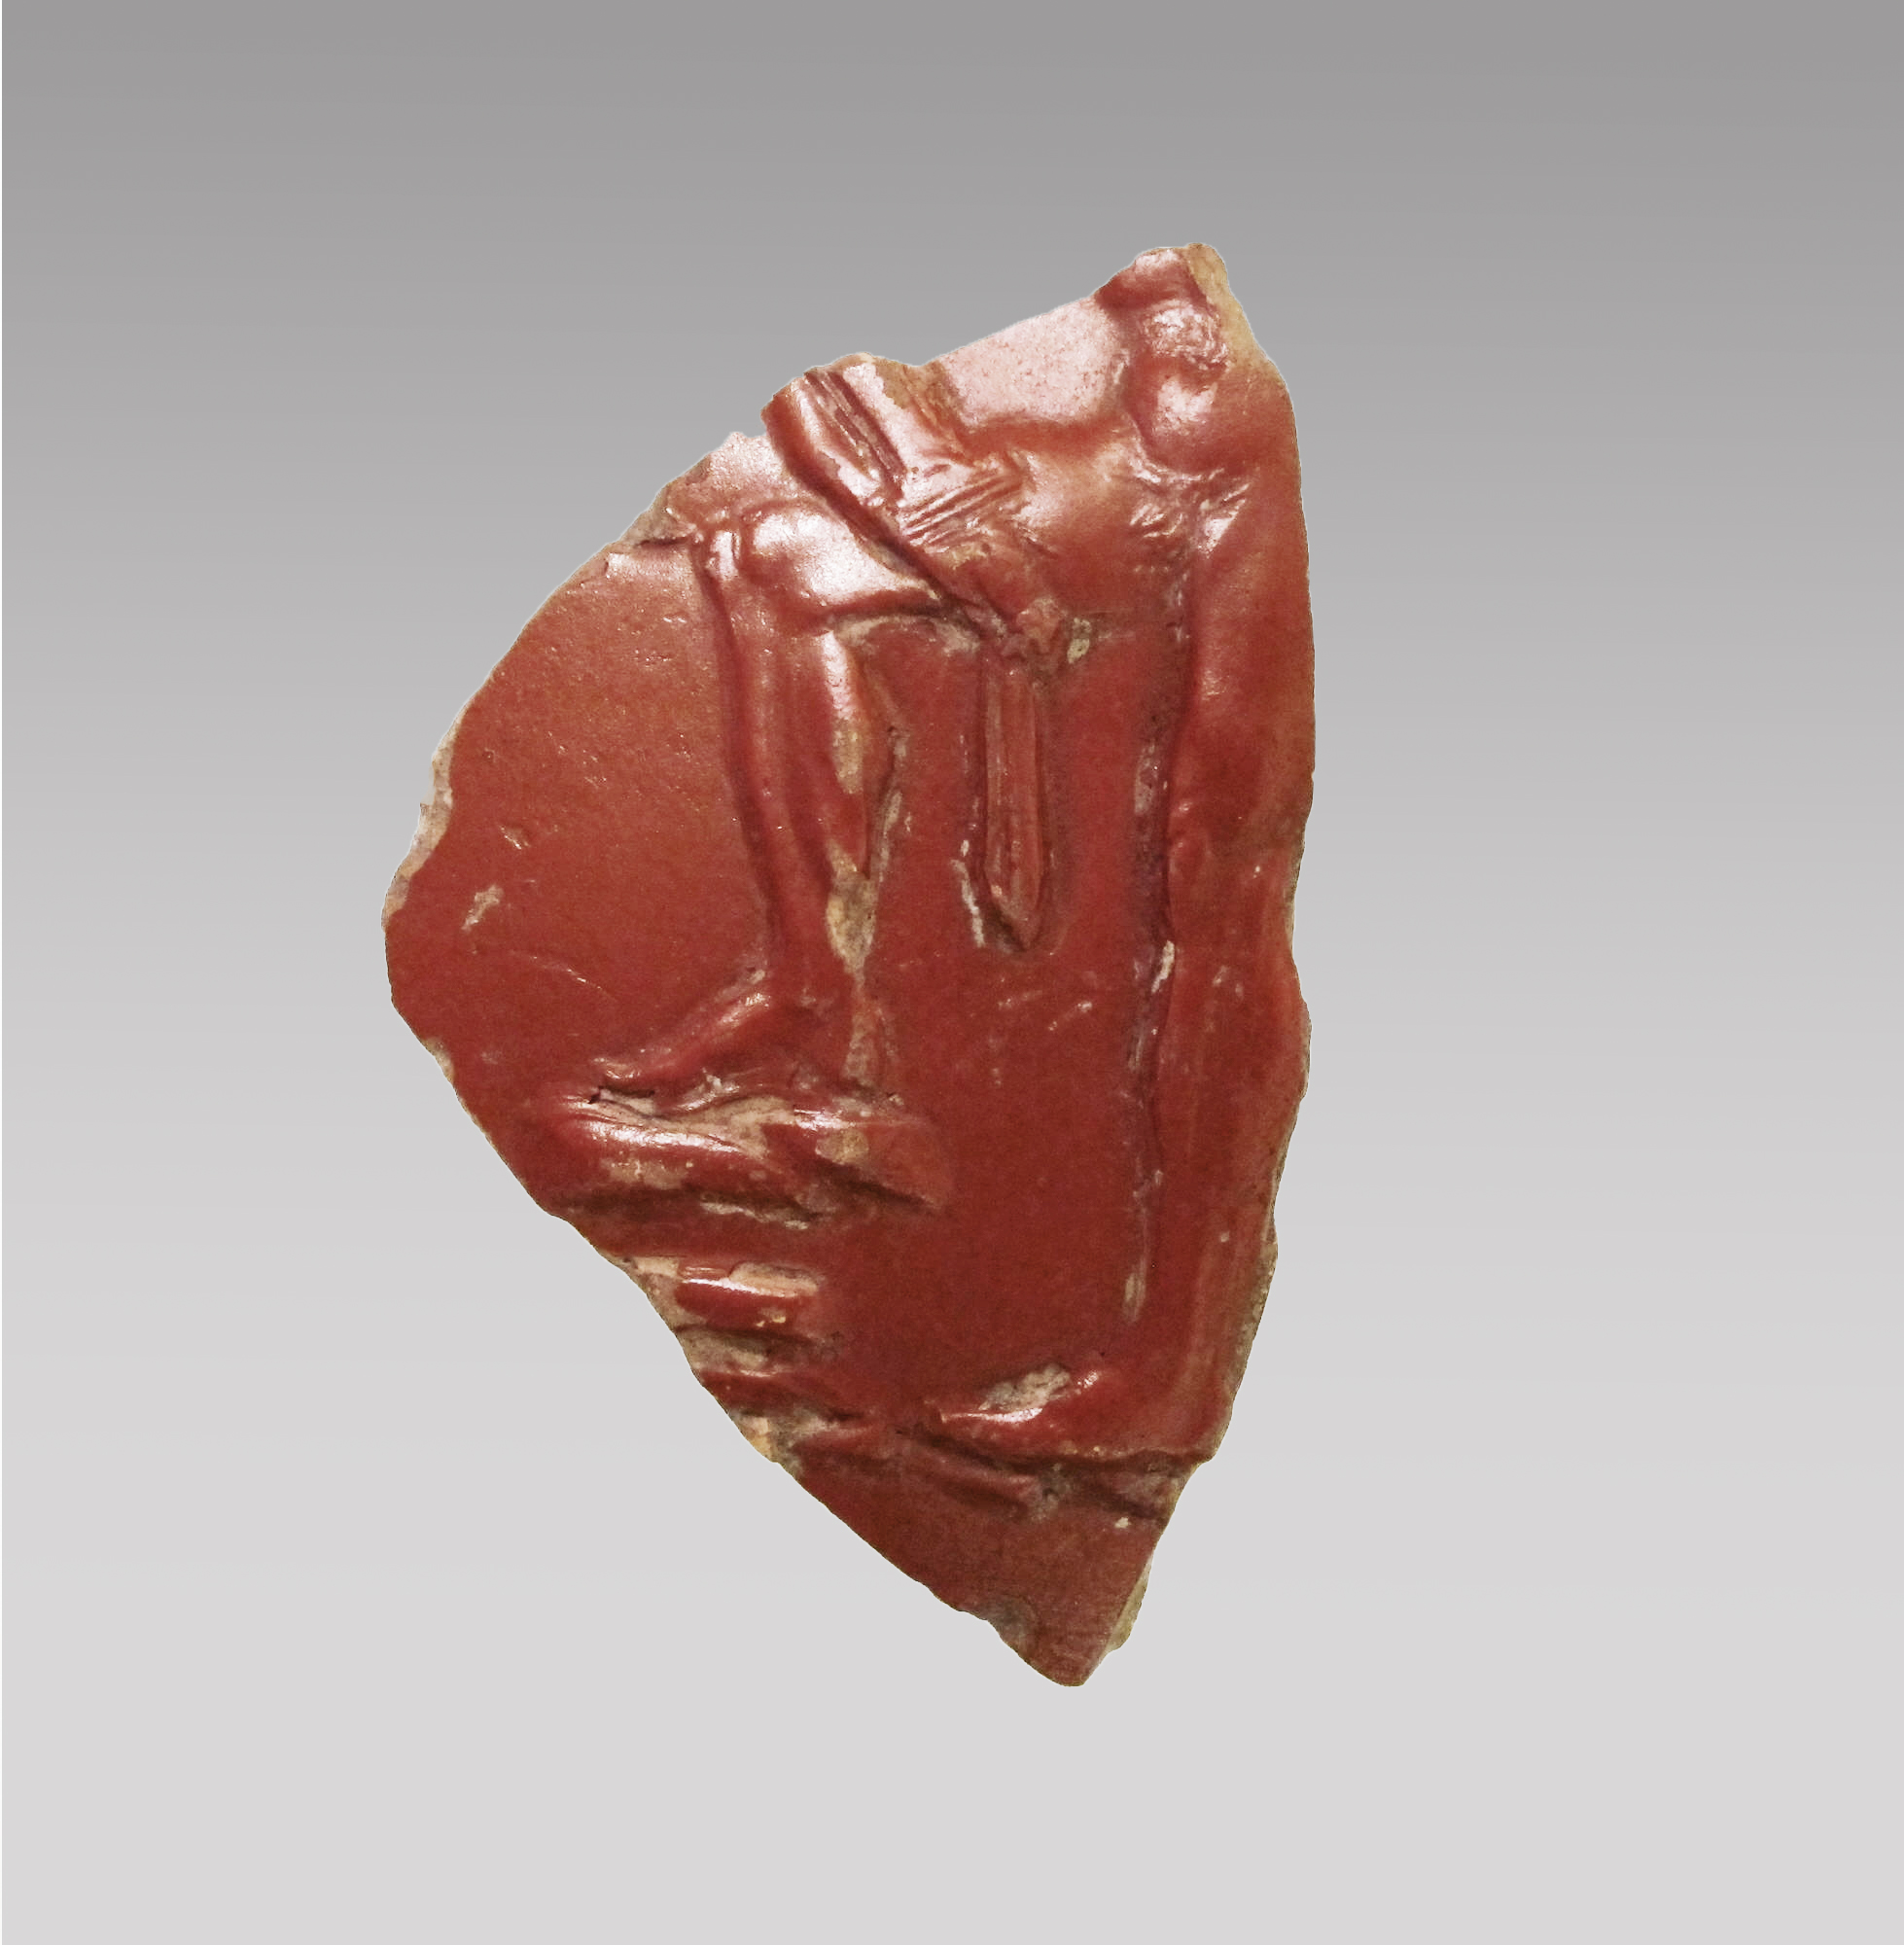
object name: vase fragment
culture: roman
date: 100 BCE-100 CE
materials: terracotta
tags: swords,legs